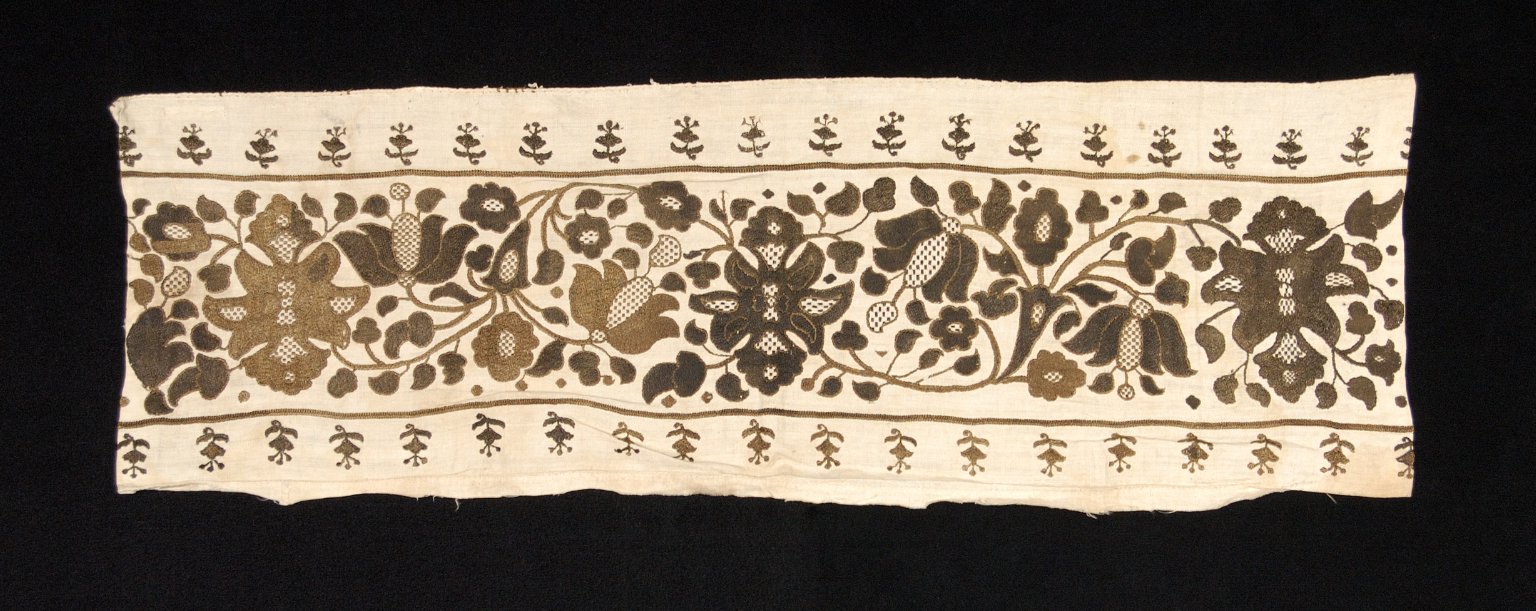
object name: textile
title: Fragment of a shirt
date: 1750-1799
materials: linen, silk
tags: flowers,leaves